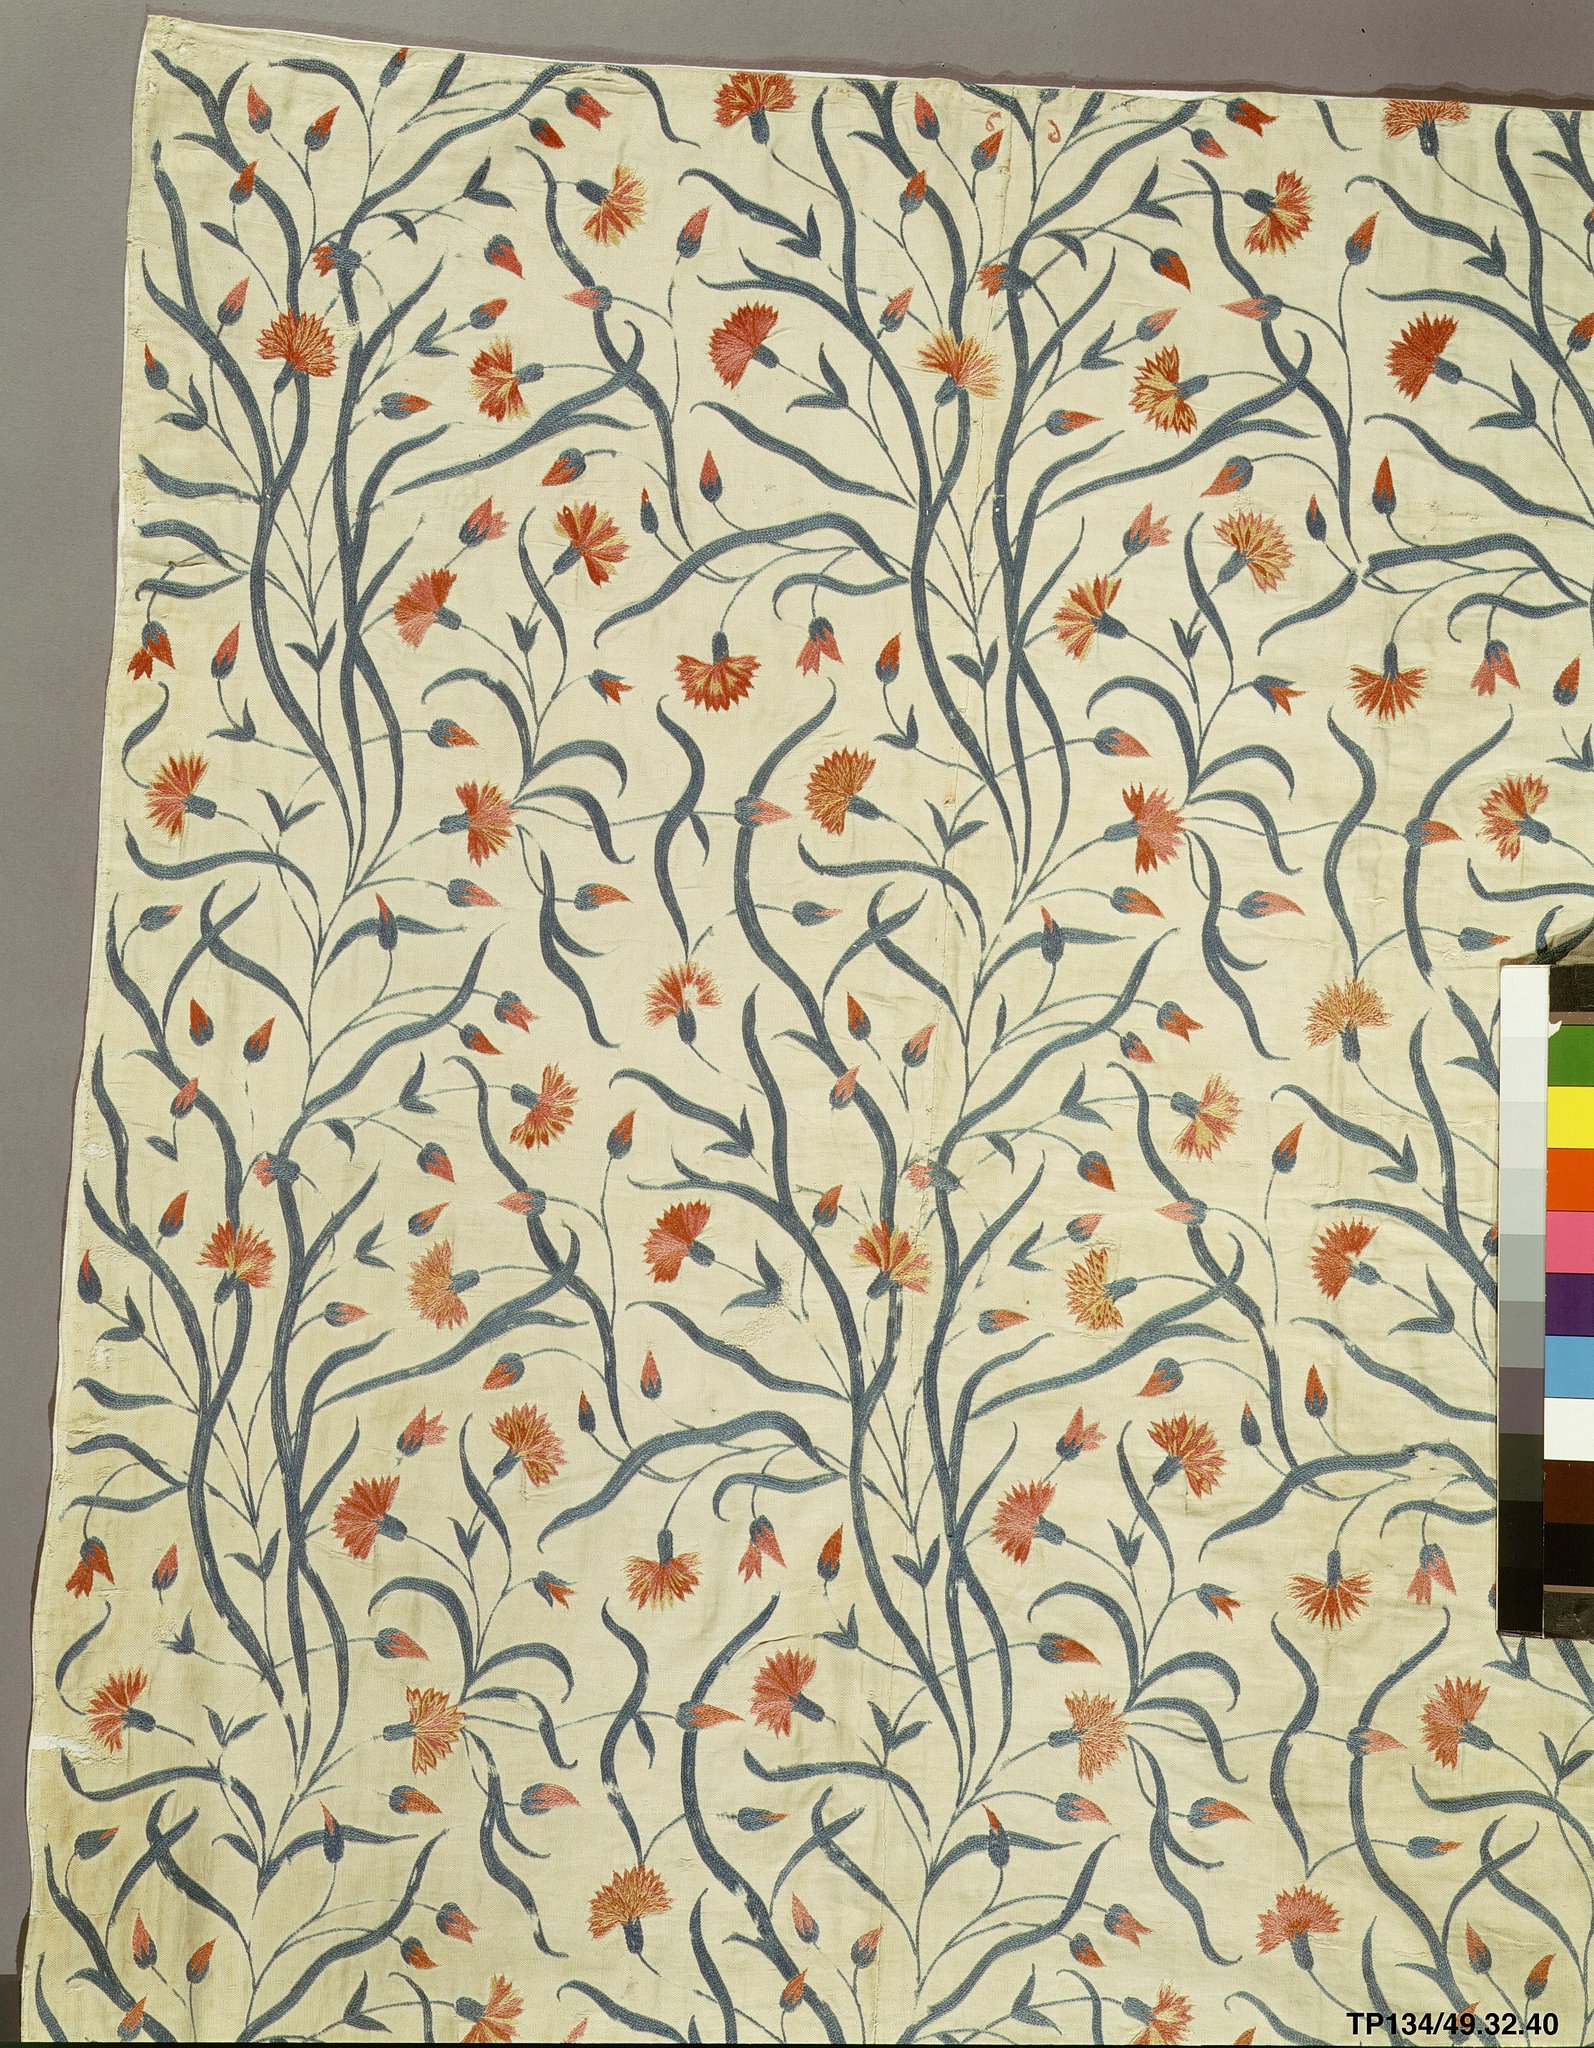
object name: piece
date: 1701-1800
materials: cotton, linen, wool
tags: flowers